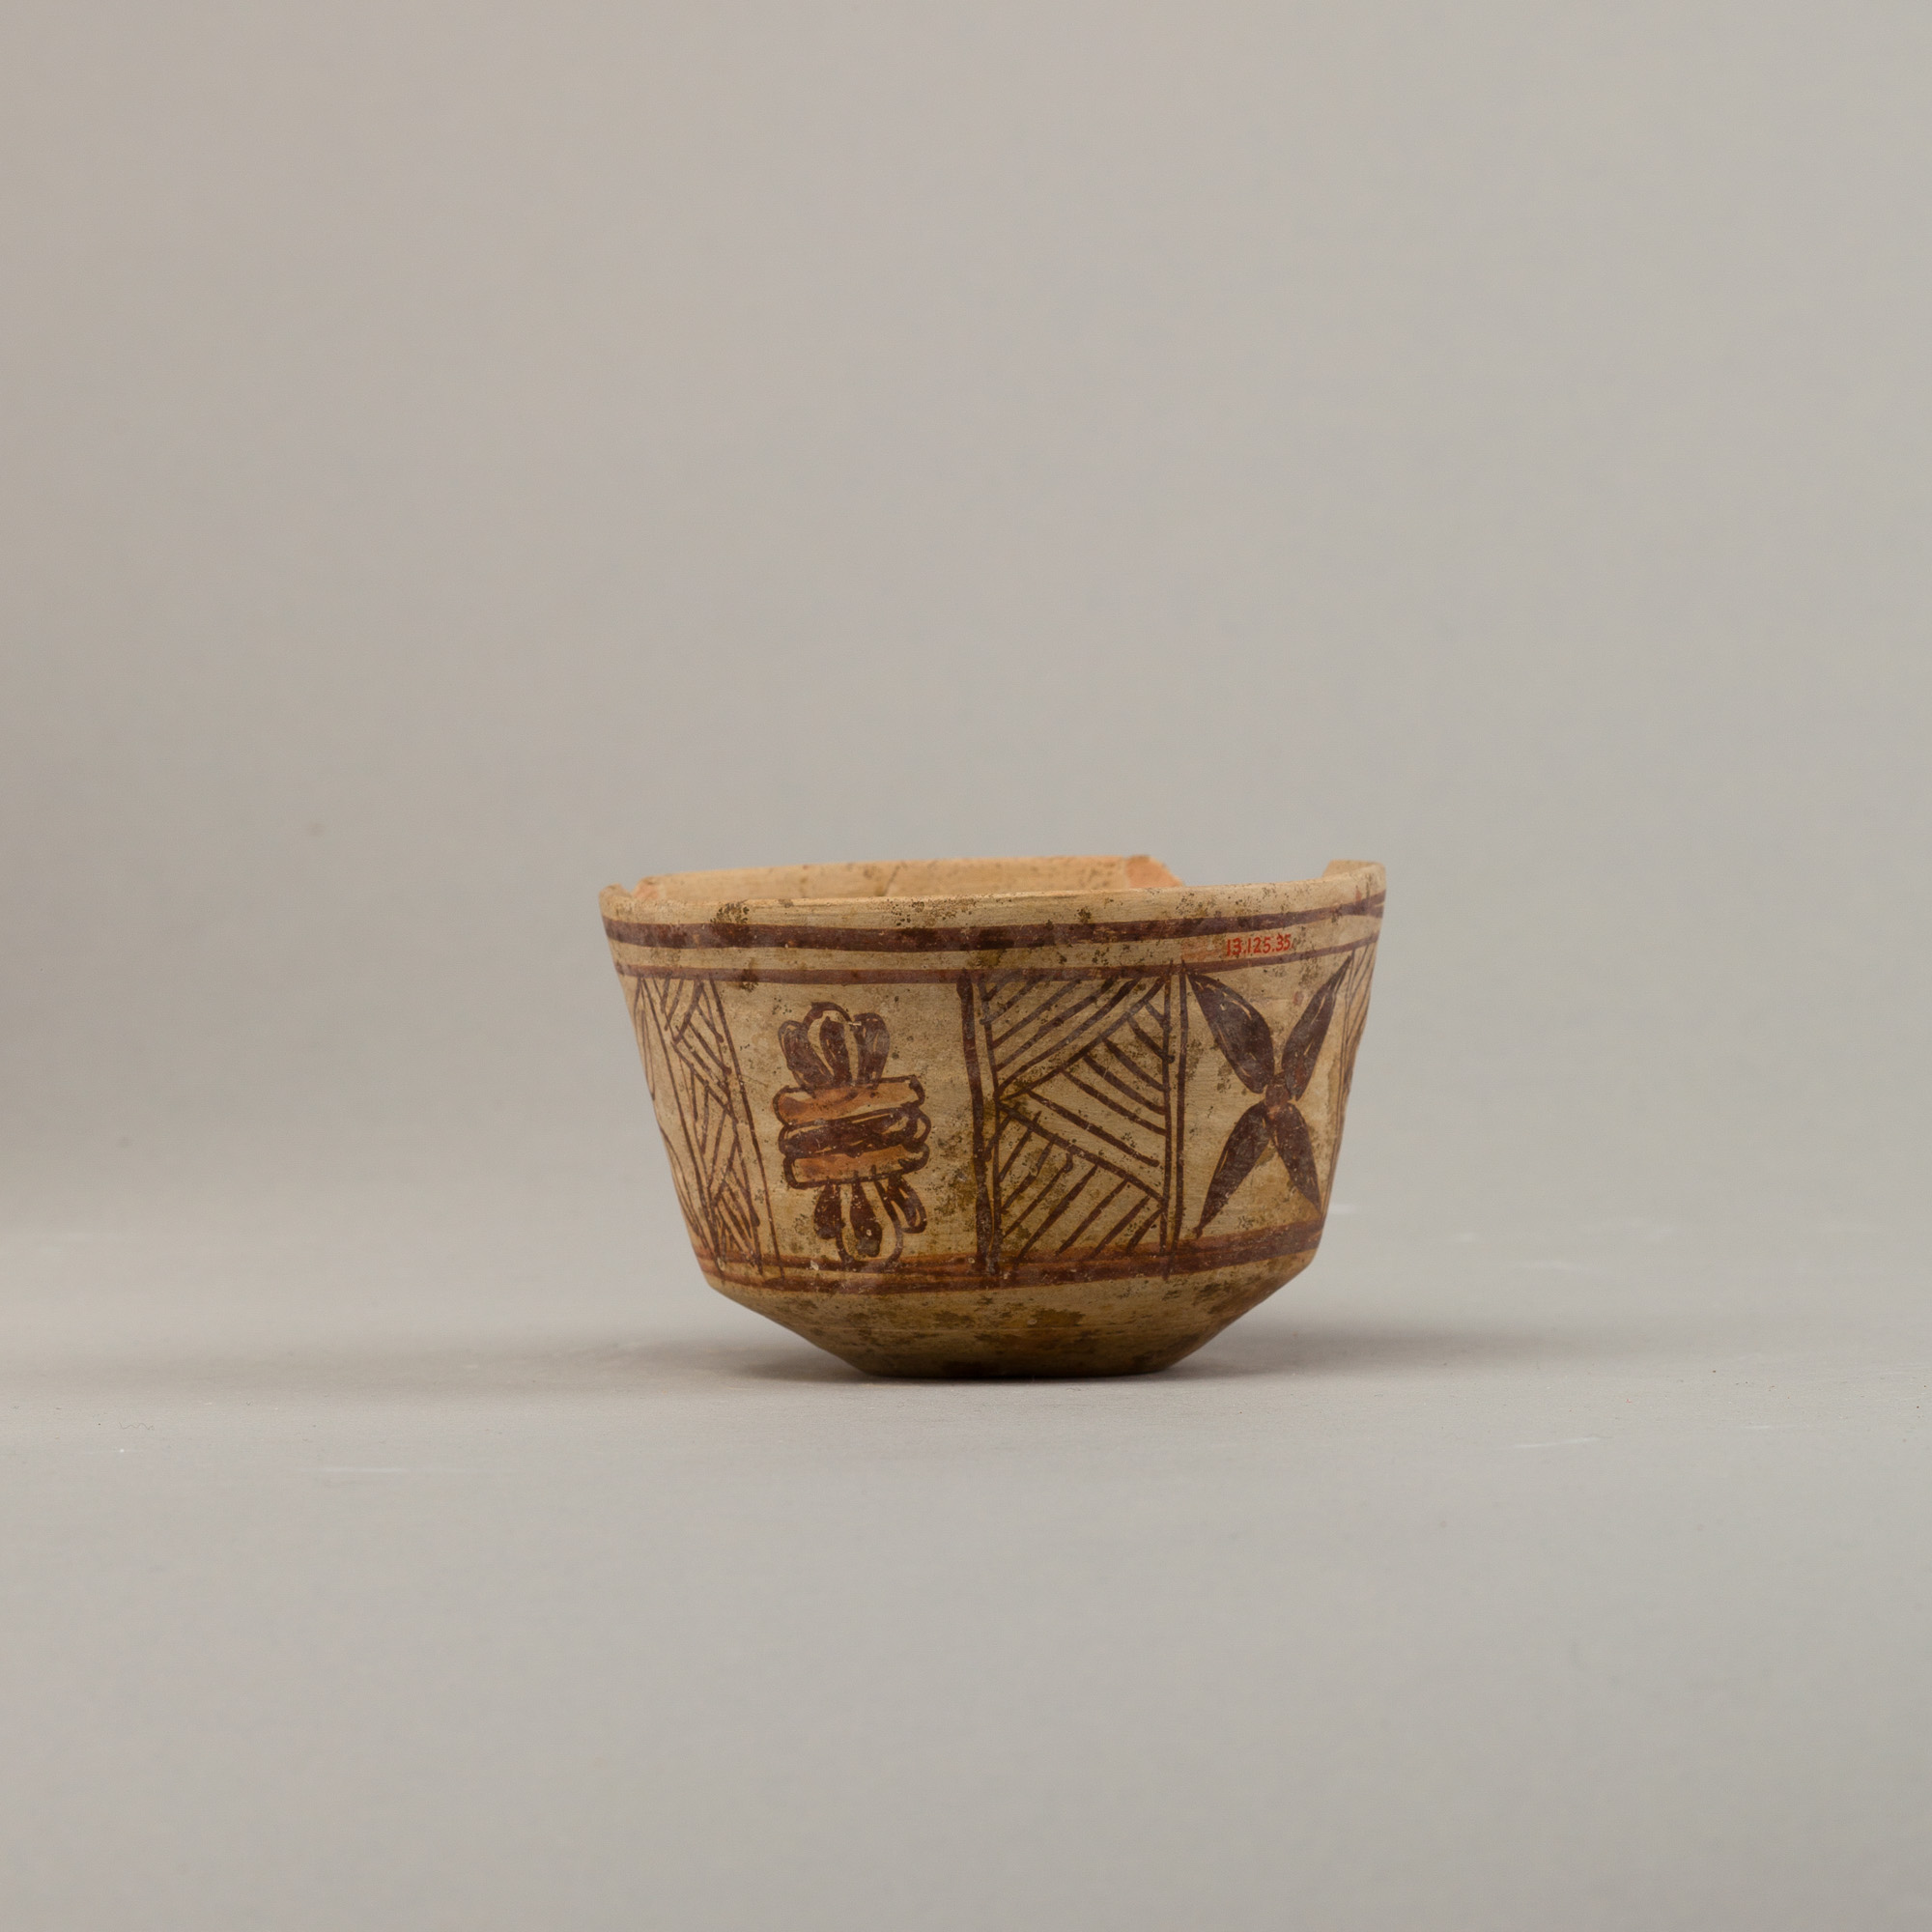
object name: bowl, geometric, floral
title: Bowl with floral and geometric designs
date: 1-300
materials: paint, pottery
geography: nubia